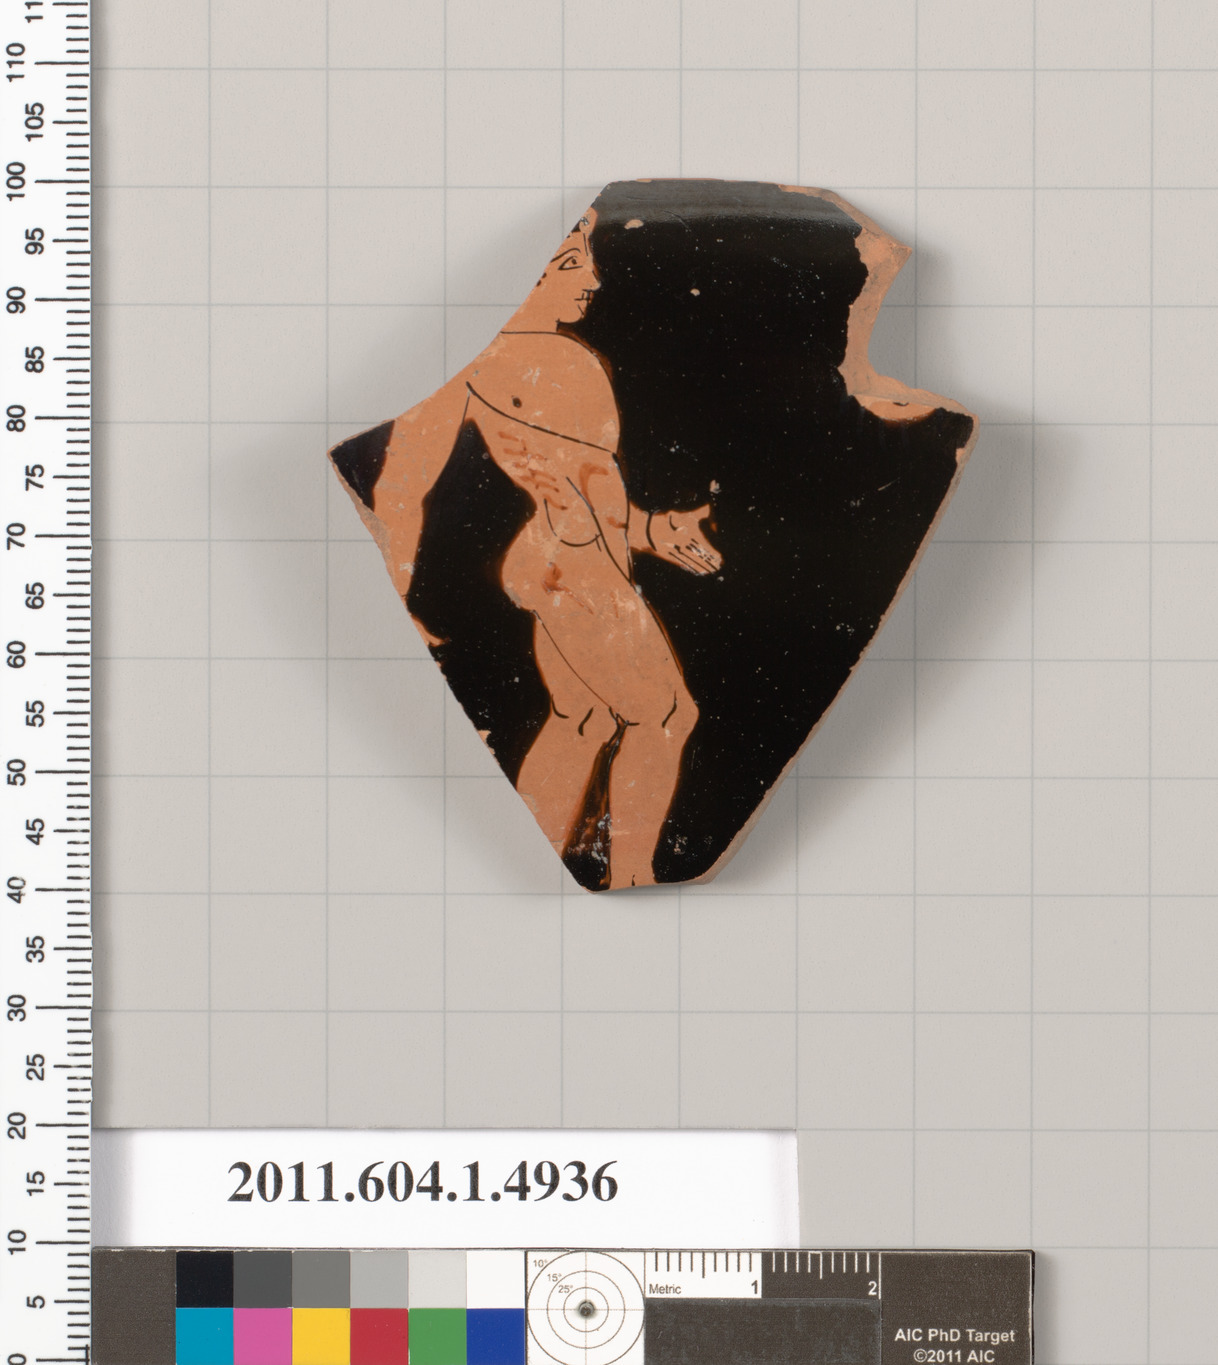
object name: kylix fragment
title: Terracotta rim fragment of a kylix (drinking cup)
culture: greek, attic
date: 467-435 BCE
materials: terracotta